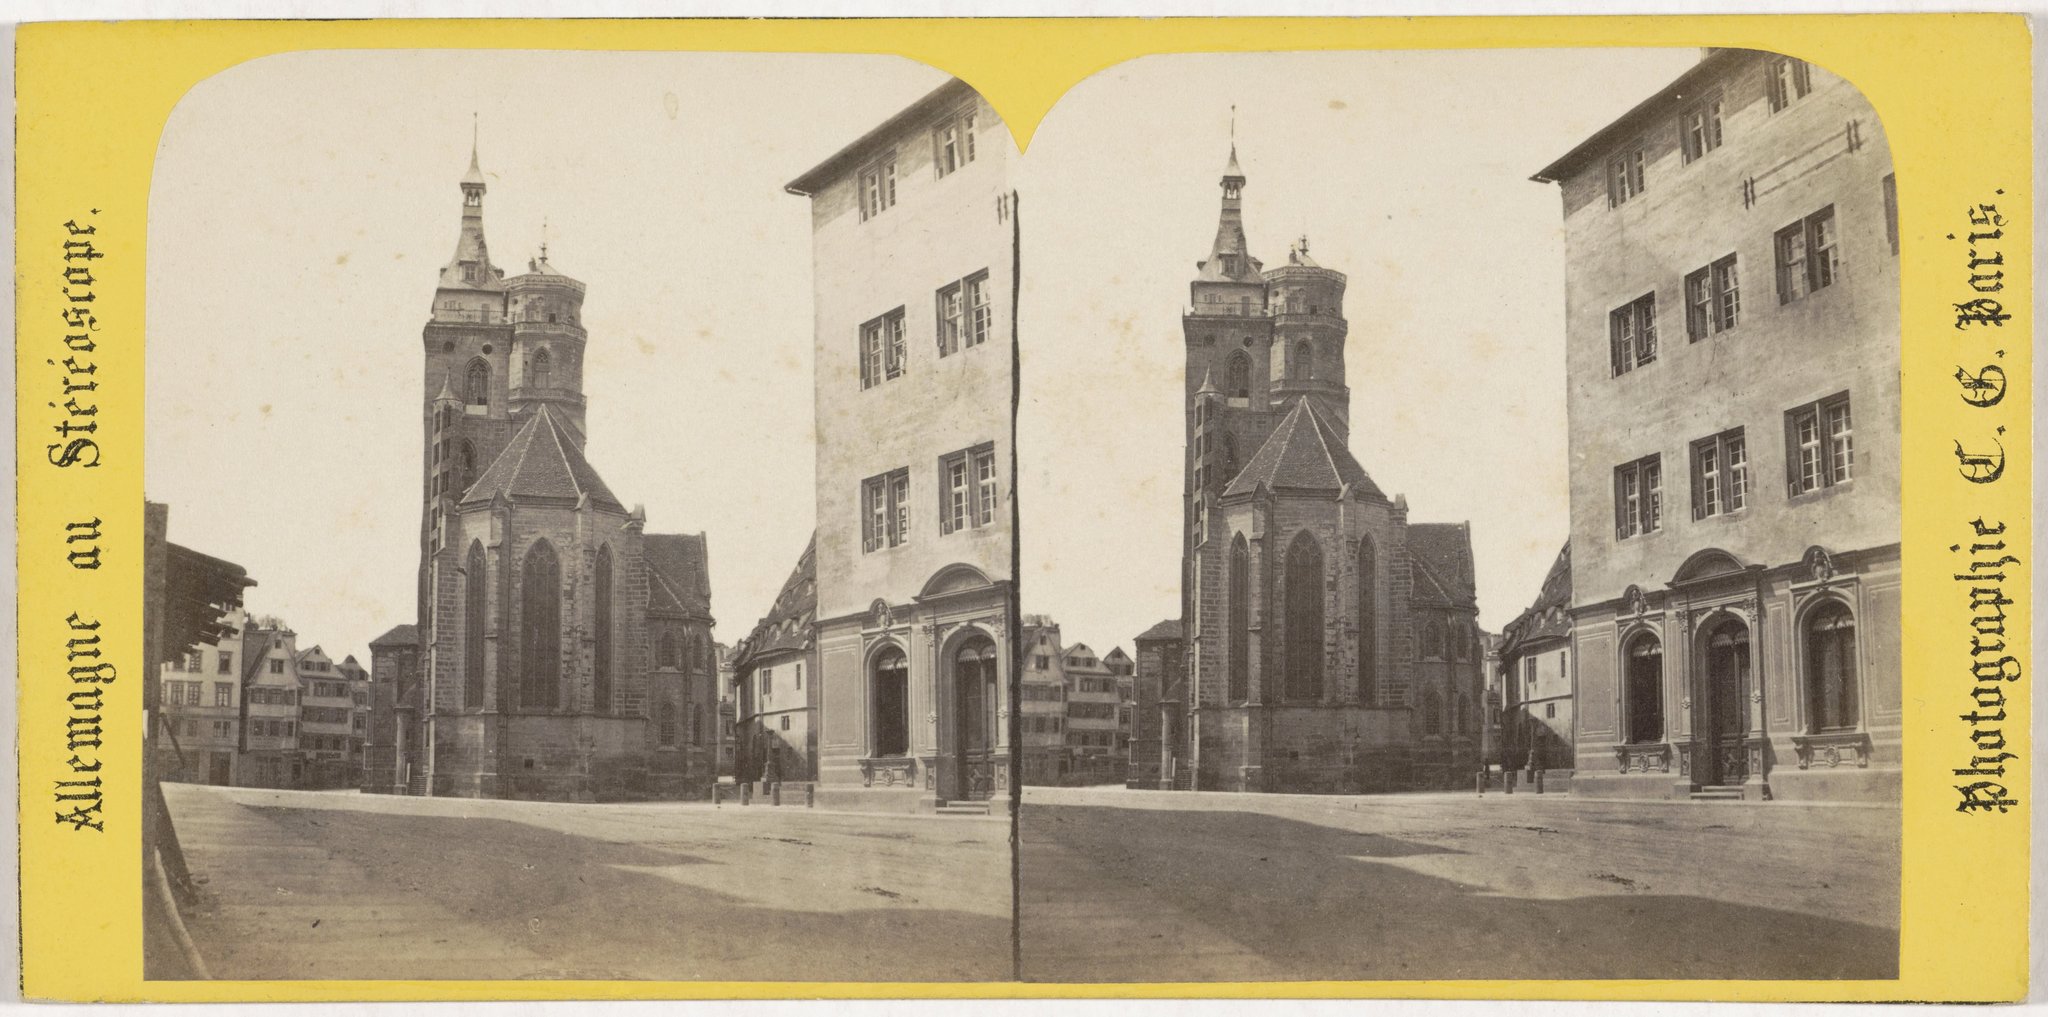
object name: stereograph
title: Stuttgart (Wurtemberg). Stistskirche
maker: charles gaudin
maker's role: publisher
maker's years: 1825-1905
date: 1868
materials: cardboard, paper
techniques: albumen print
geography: stuttgart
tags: church (exterior)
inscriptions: inscription: ‘9’, number: ‘9.’